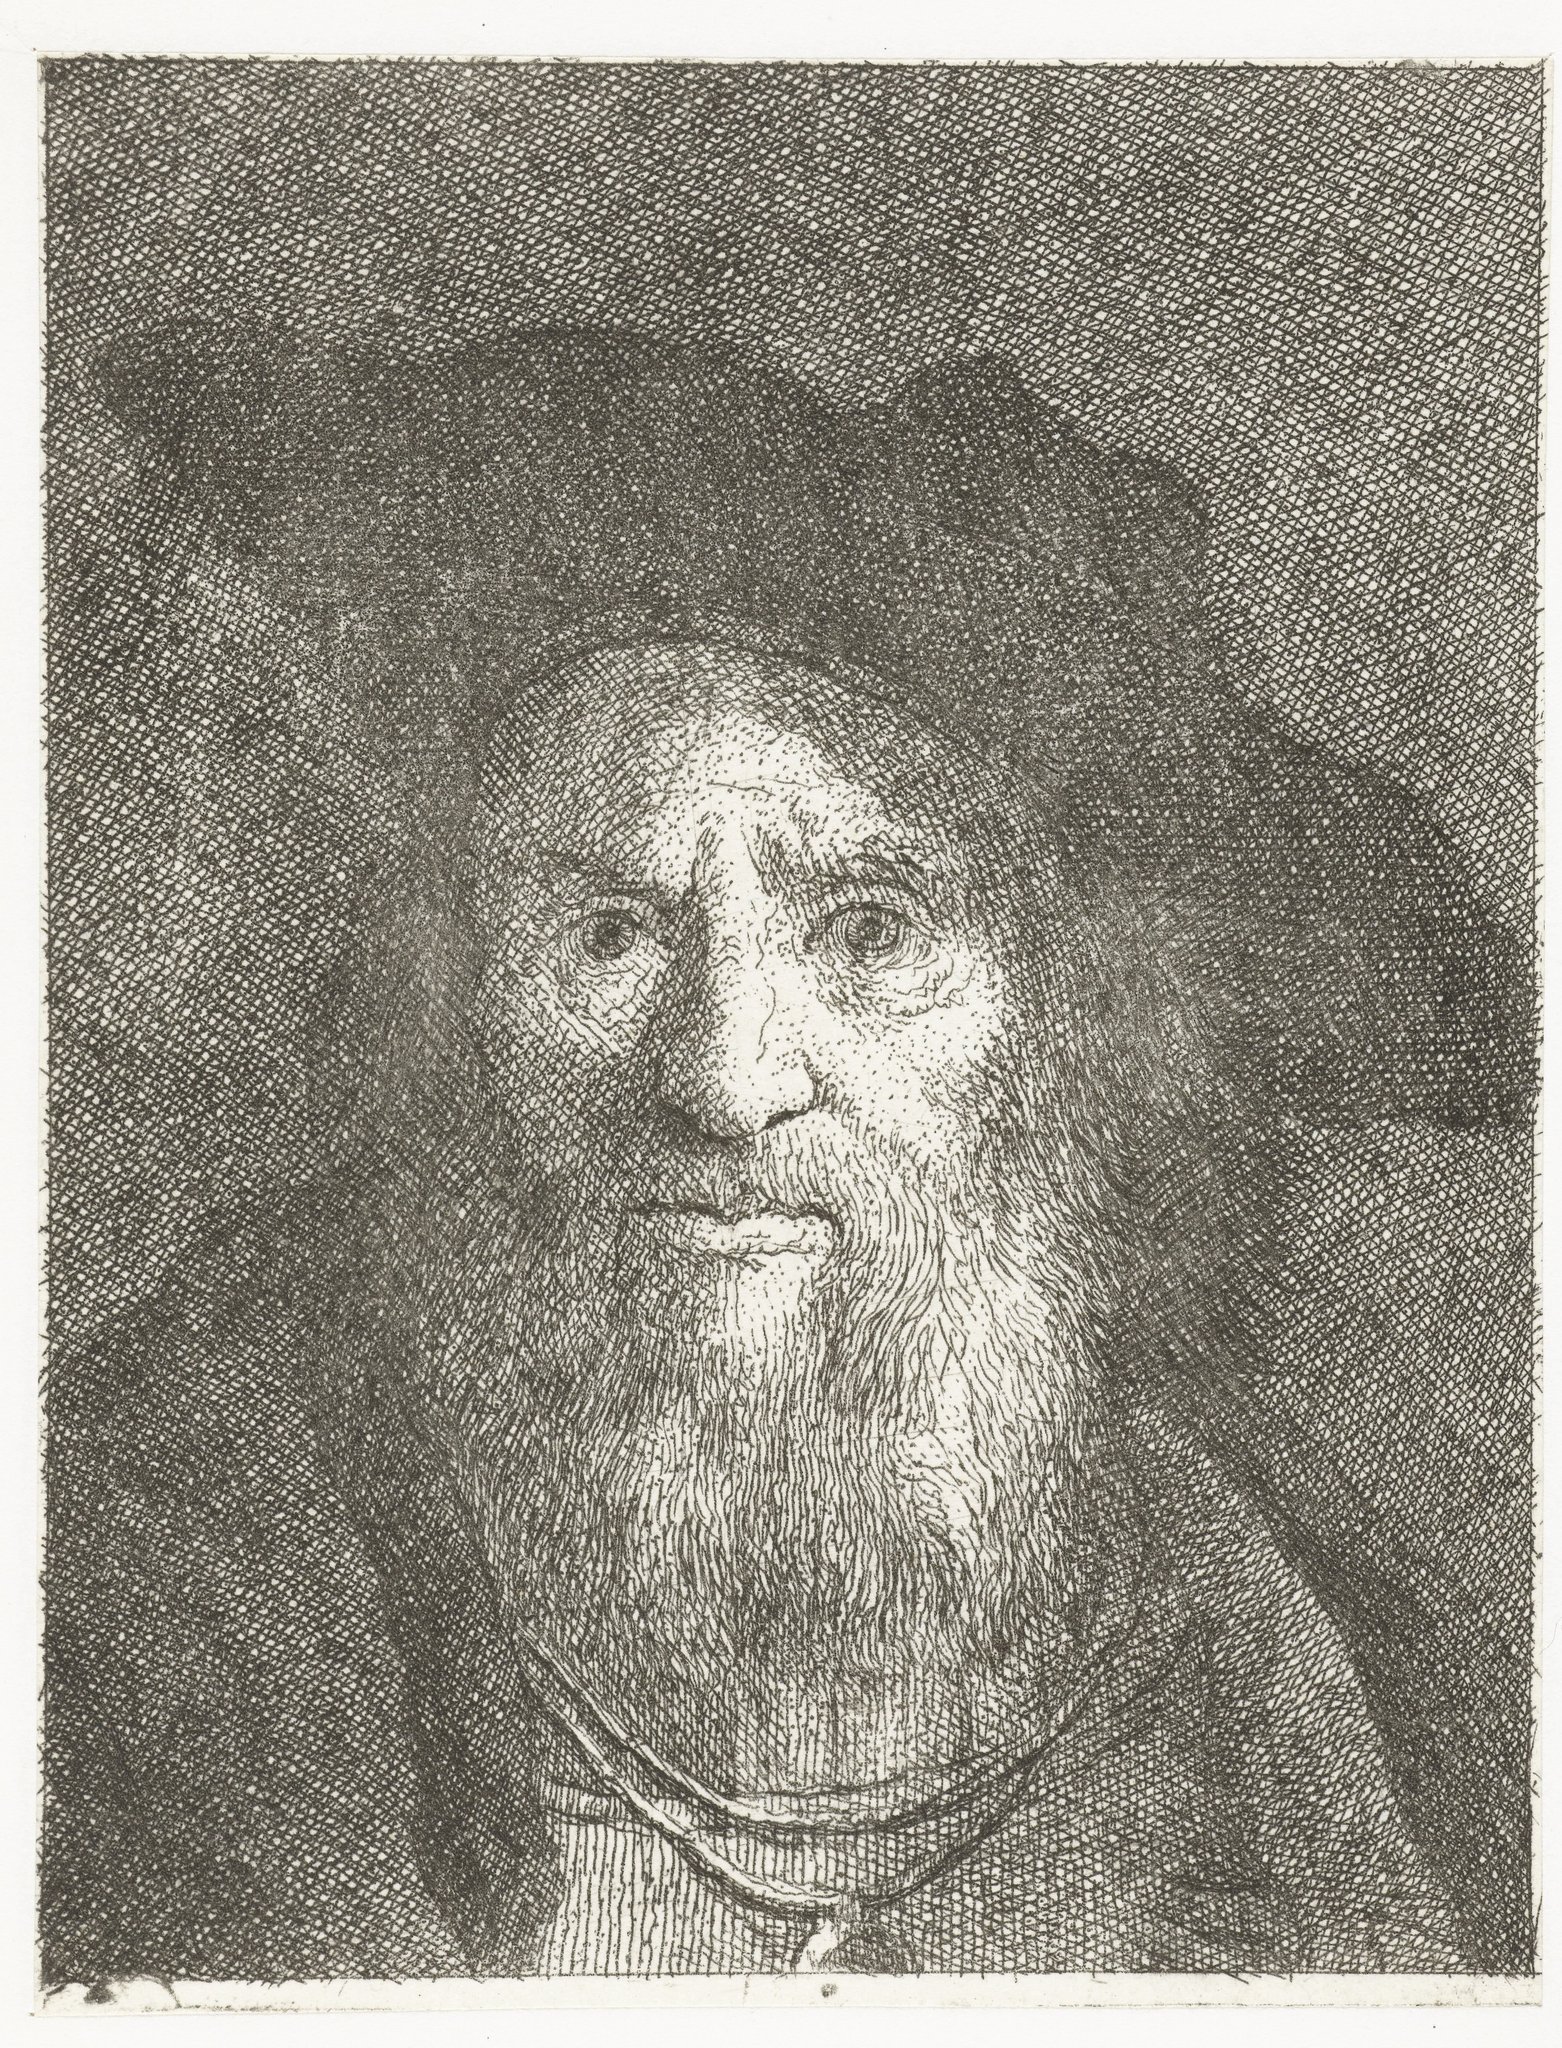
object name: print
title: Verzameling hoofden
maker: giovanni domenico tiepolo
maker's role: draughtsman, print maker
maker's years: 1727-1804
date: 1757-1758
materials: paper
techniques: etching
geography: venice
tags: head-gear: hat (+ men's clothes), old man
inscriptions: collector's mark: Lugt 2228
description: Prent uit serie Verzameling hoofden (Raccolta di teste). Giovanni Domenico Tiepolo vervaardigde in de winter van 1757-1758 en in de periode van 1771-1774 deze hoofden naar schilderijen en tekeningen van Giovanni Battista Tiepolo. De eerste uitgave verscheen in 1774 in twee delen met elk dertig prenten. Deze prent werd werd in de tweede staat met serienummer 25 opgenomen in deel 2.